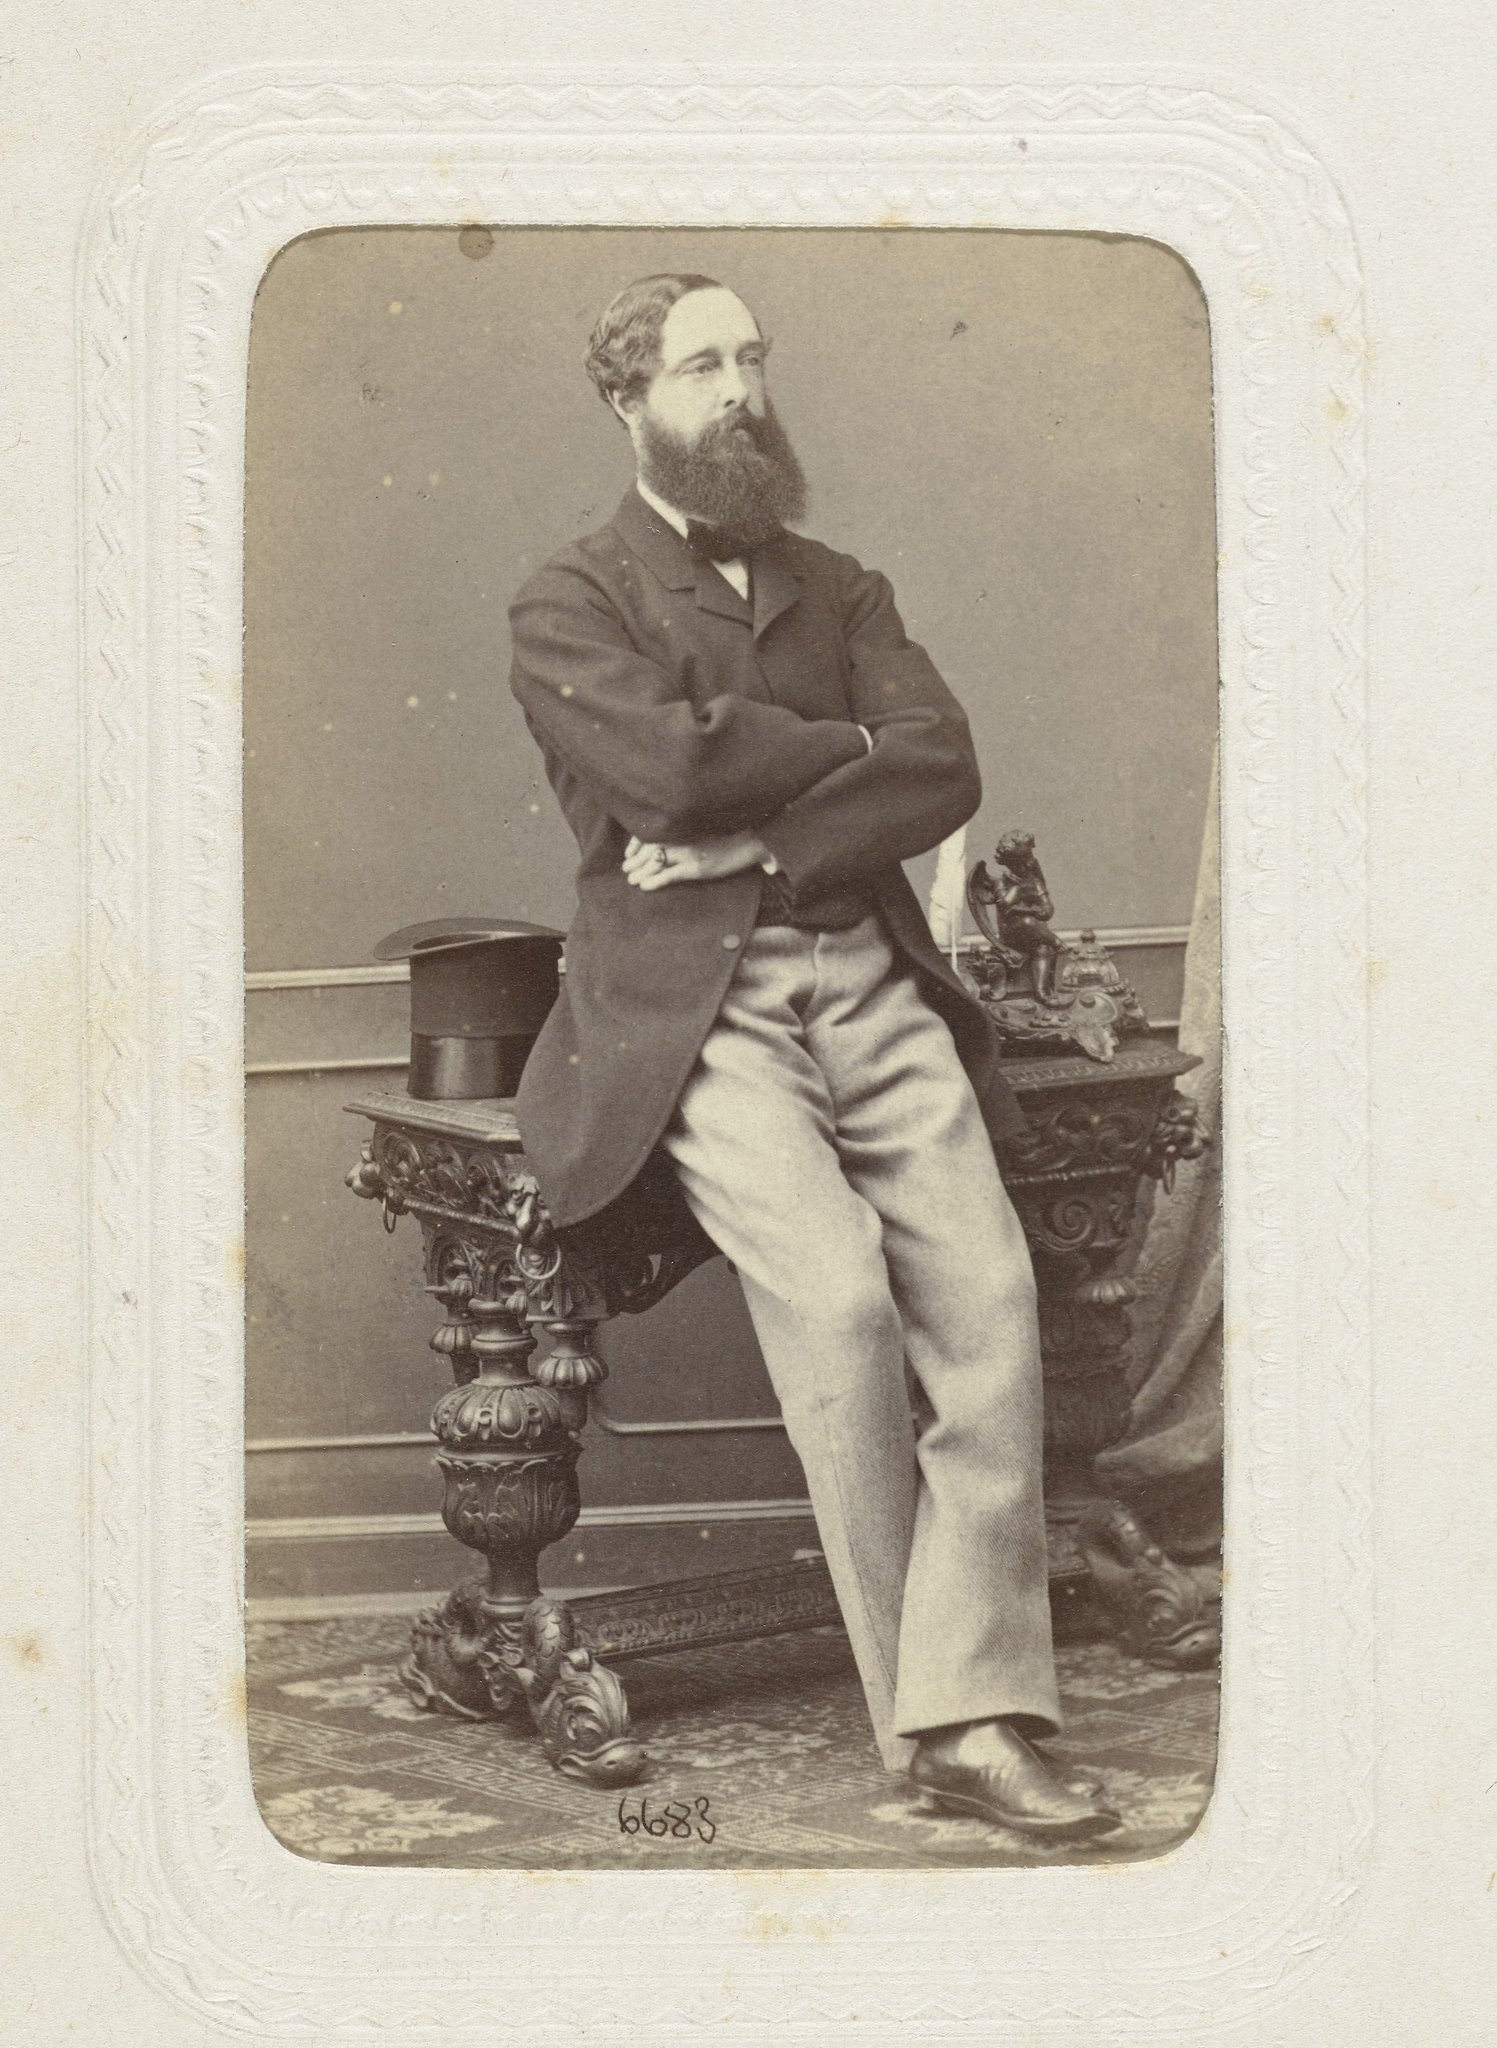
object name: carte de visite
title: Studioportret van een man met een lange baard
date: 1863-1866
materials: cardboard, paper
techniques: albumen print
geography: istanbul